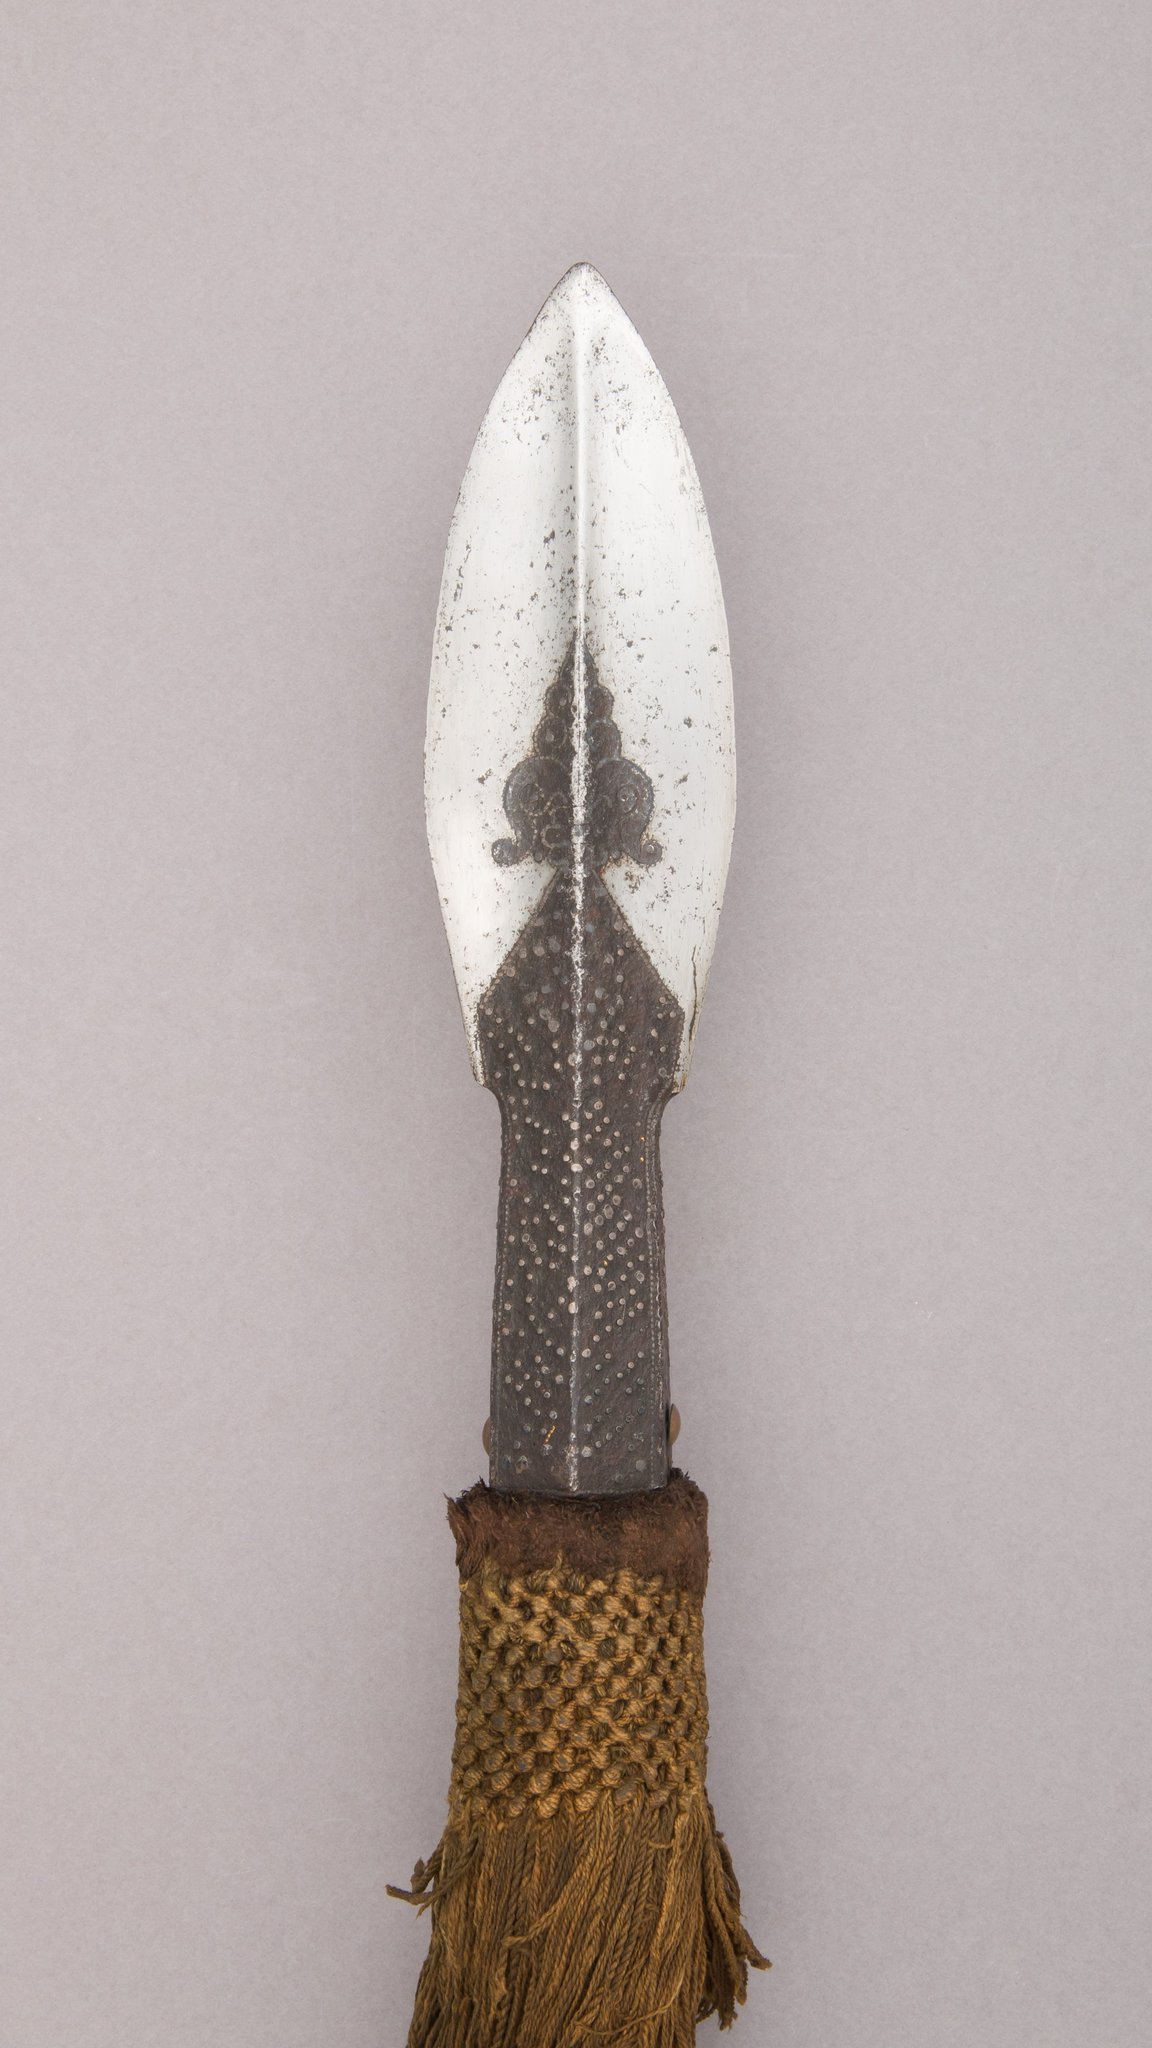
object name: hunting spear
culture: french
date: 1501-1600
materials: copper alloy, gold, leather, steel, textile, wood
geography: france